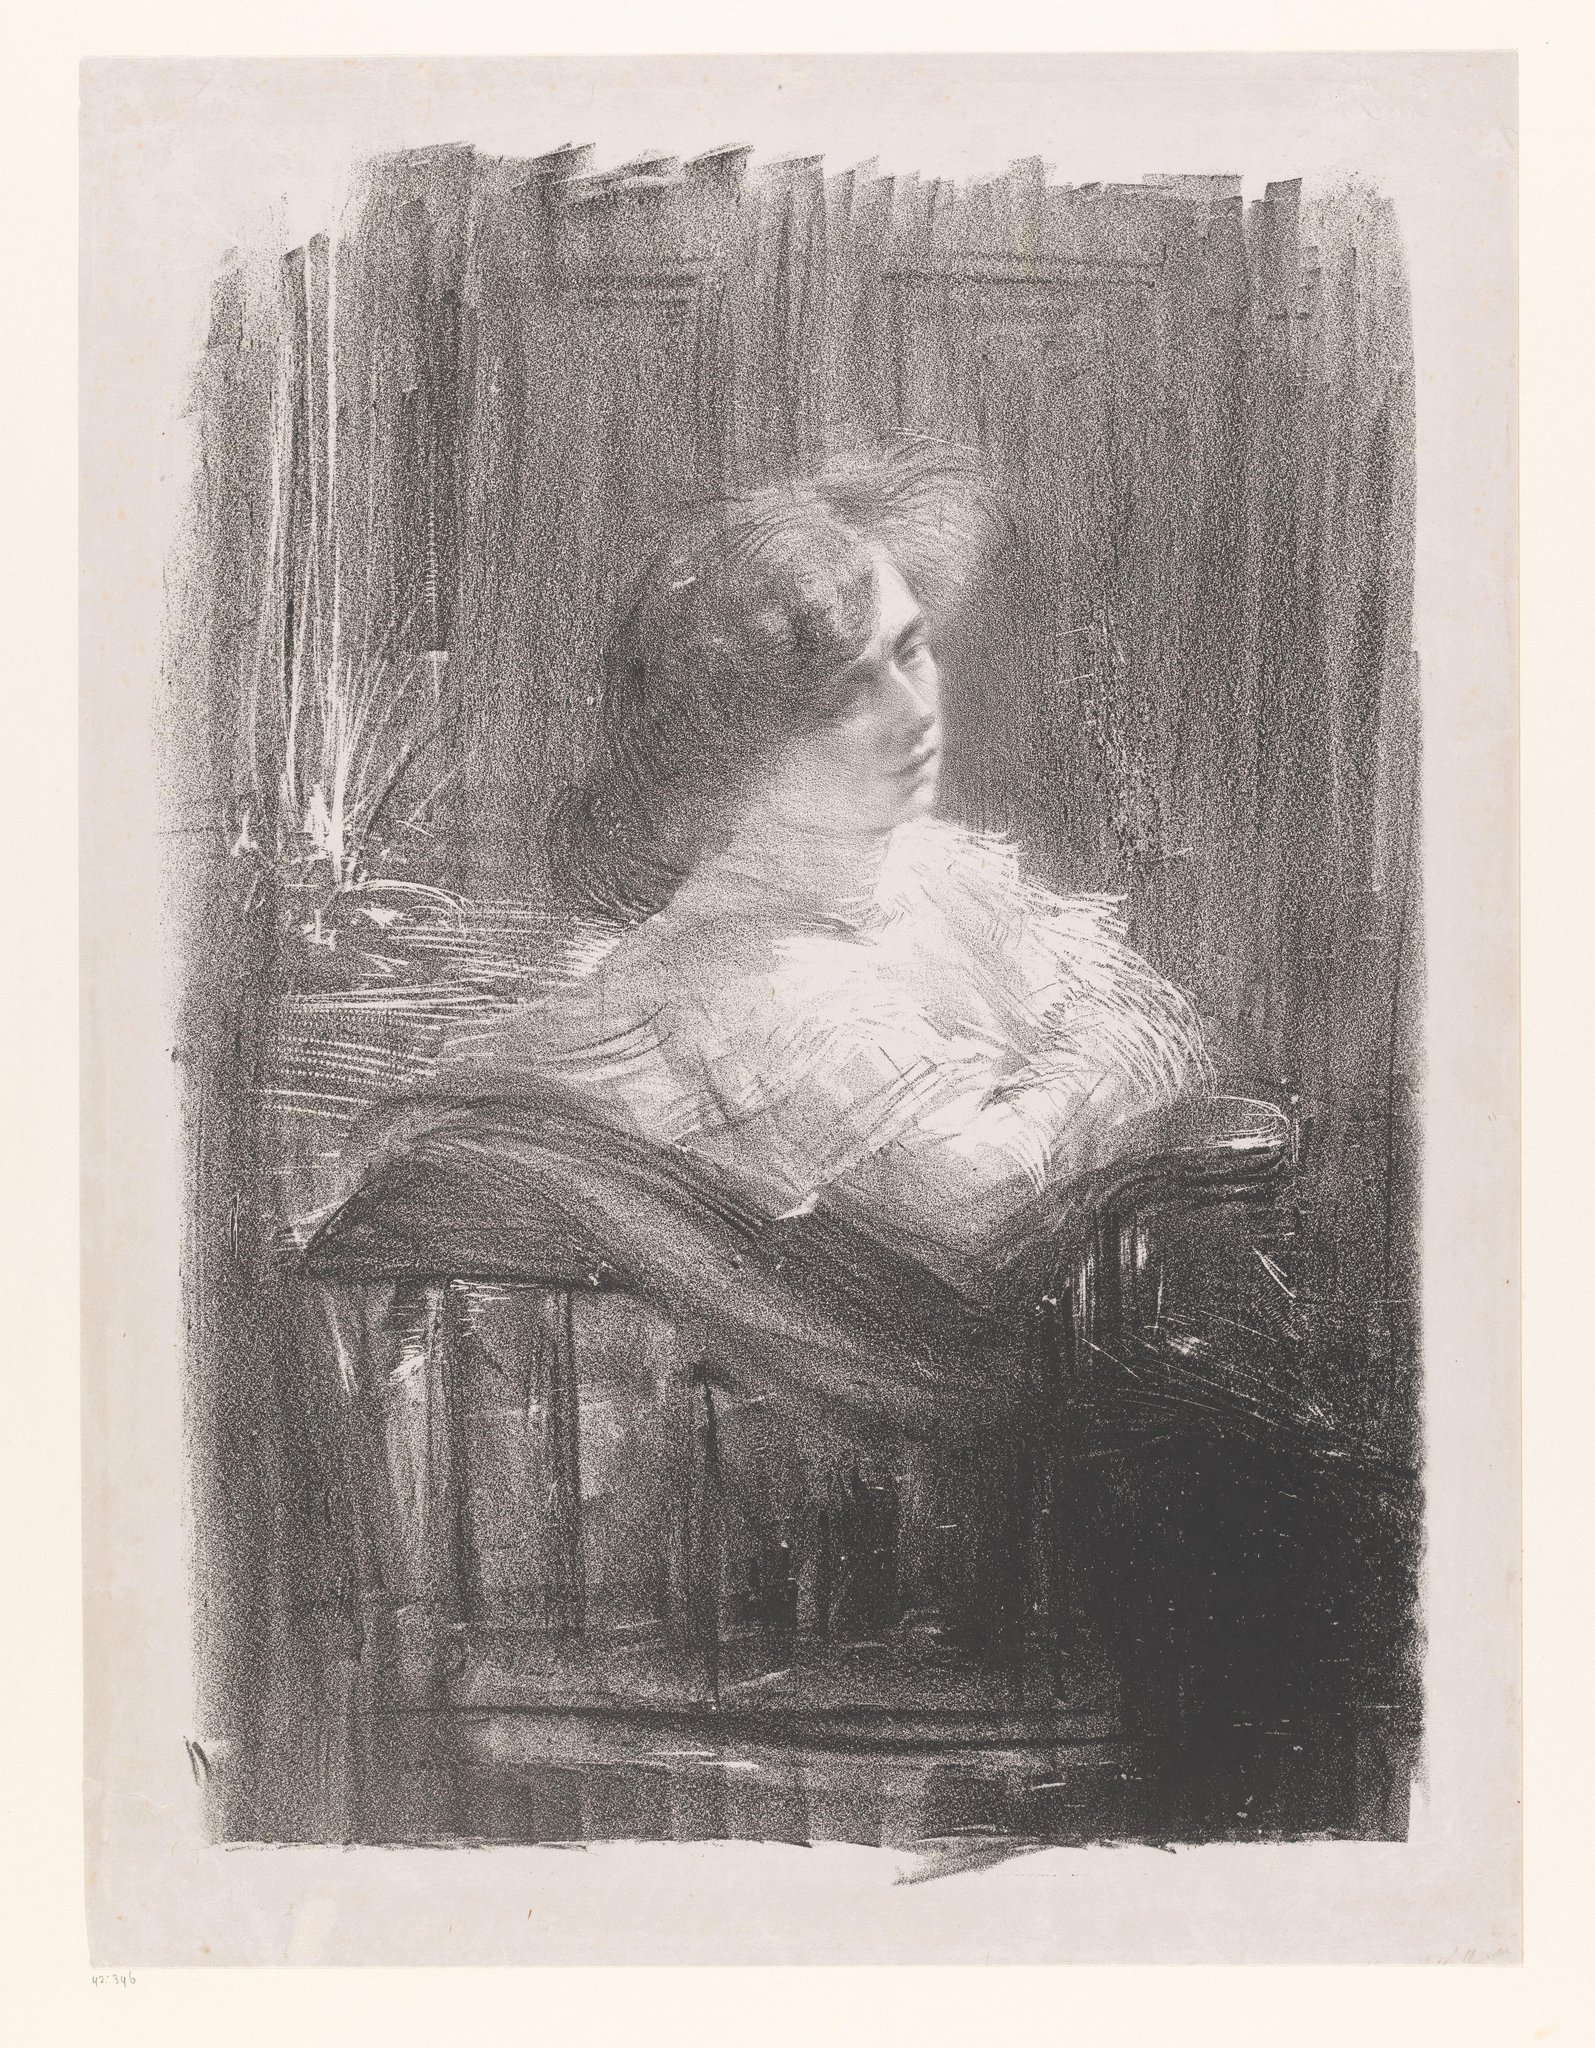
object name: print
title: Vrouw in gebed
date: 1864-1934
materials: paper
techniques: lithograph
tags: adult woman, one person praying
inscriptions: collector's mark: Lugt 2228